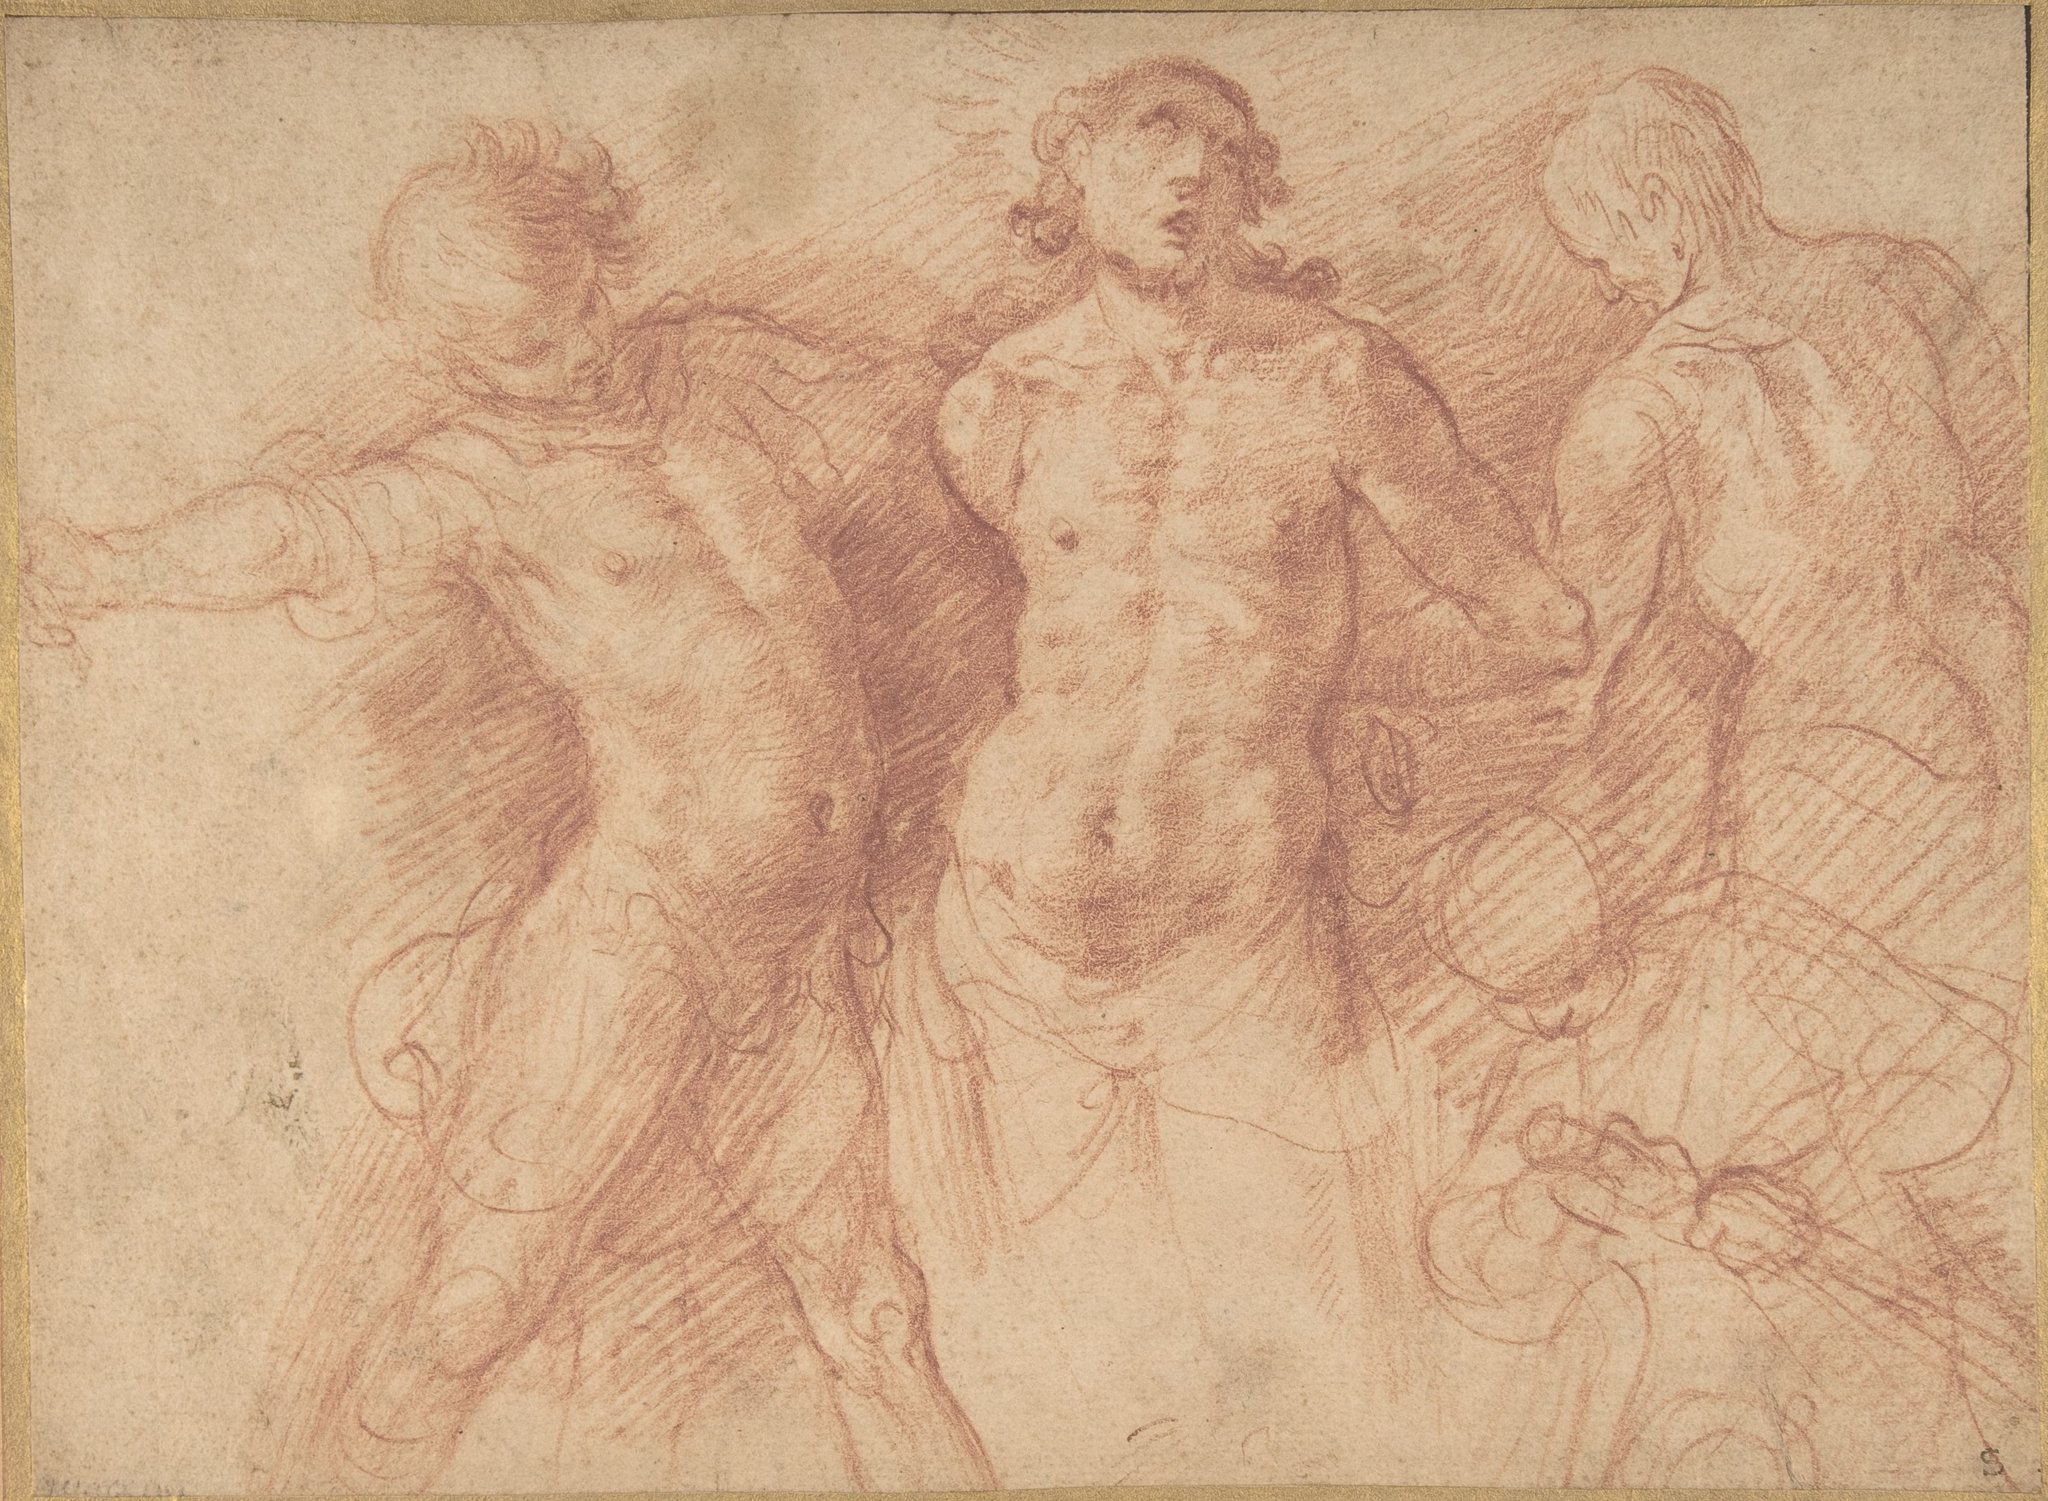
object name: drawing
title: The Flagellation of Christ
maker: bernardo cavallino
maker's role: artist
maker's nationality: italian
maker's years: 1616-1656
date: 1601-1700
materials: chalk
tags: men,christ